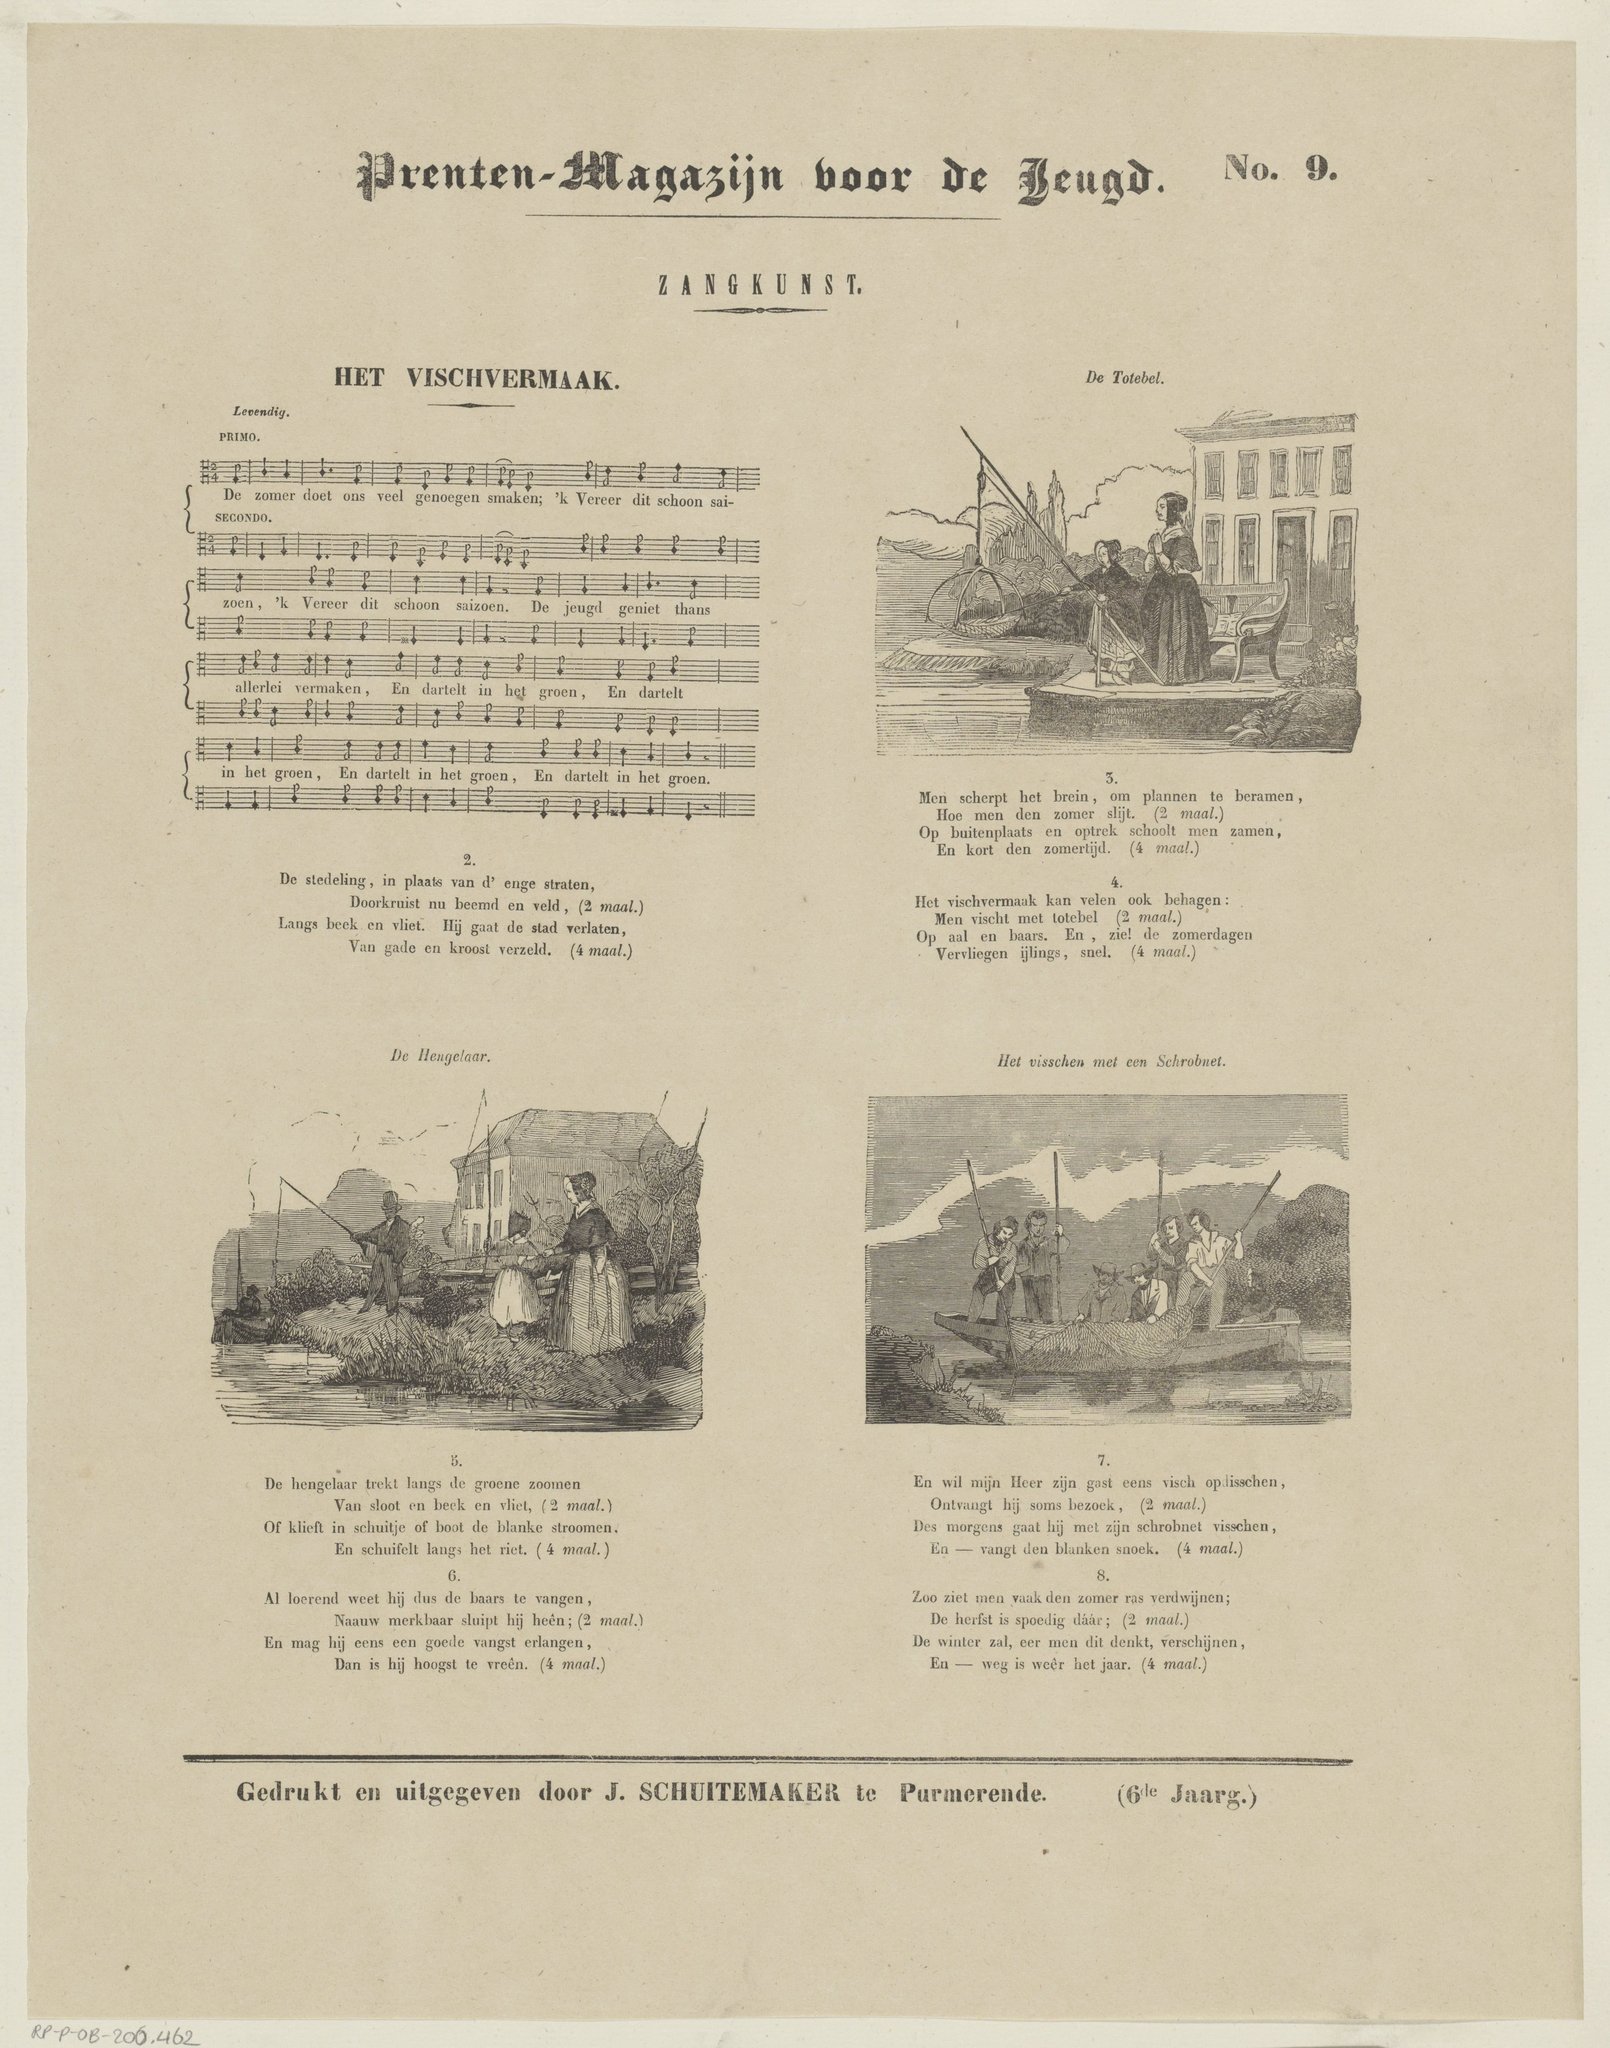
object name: print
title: Prenten-magazijn voor de jeugd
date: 1847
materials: paper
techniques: letterpress printing, engraving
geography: netherlands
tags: fishing (sports)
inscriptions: collector's mark: Lugt 2760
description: Blad met 3 voorstellingen en een stuk bladmuziek met een lied over vissen vangen. Boven elke voorstelling een titel en onder elke voorstelling coupletten van het lied. Genummerd rechtsboven: No. 9.